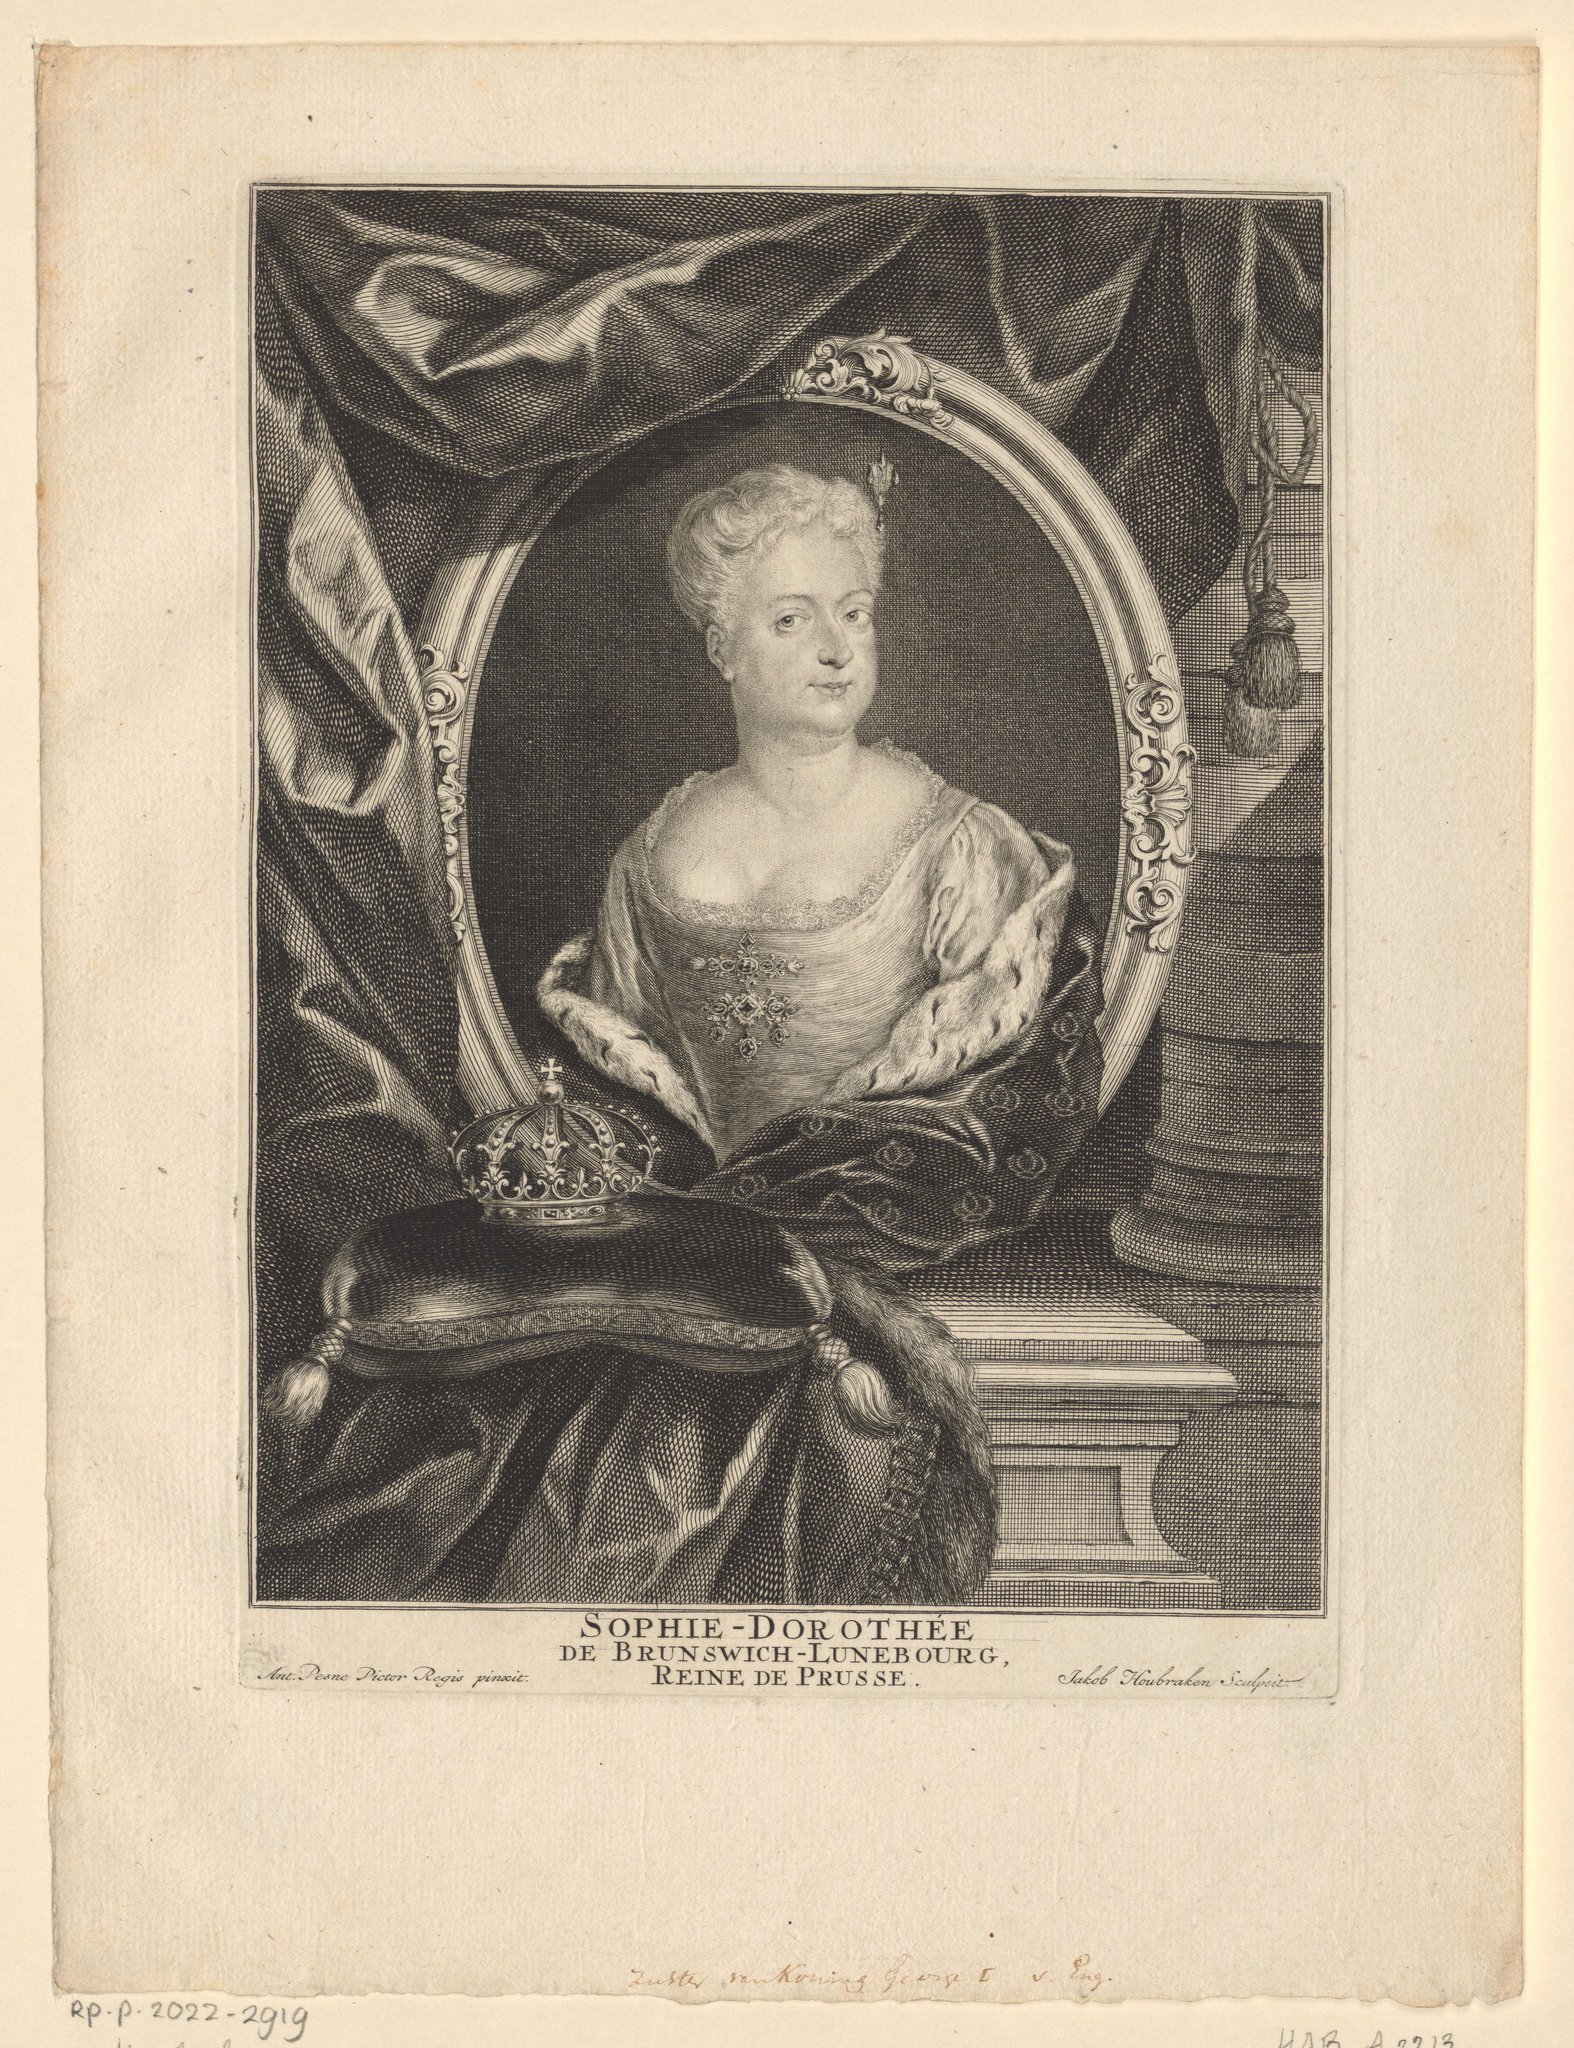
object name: print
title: Portret van Sophia Dorothea van Hannover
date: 1713-1740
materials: paper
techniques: engraving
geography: amsterdam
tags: berlin, historical persons - bb - woman, queen, empress, etc. (wife of a ruler)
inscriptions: inscription: ‘zuster vanKoning George I v Eng.’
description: Met drieregelig onderschrift in het Frans.